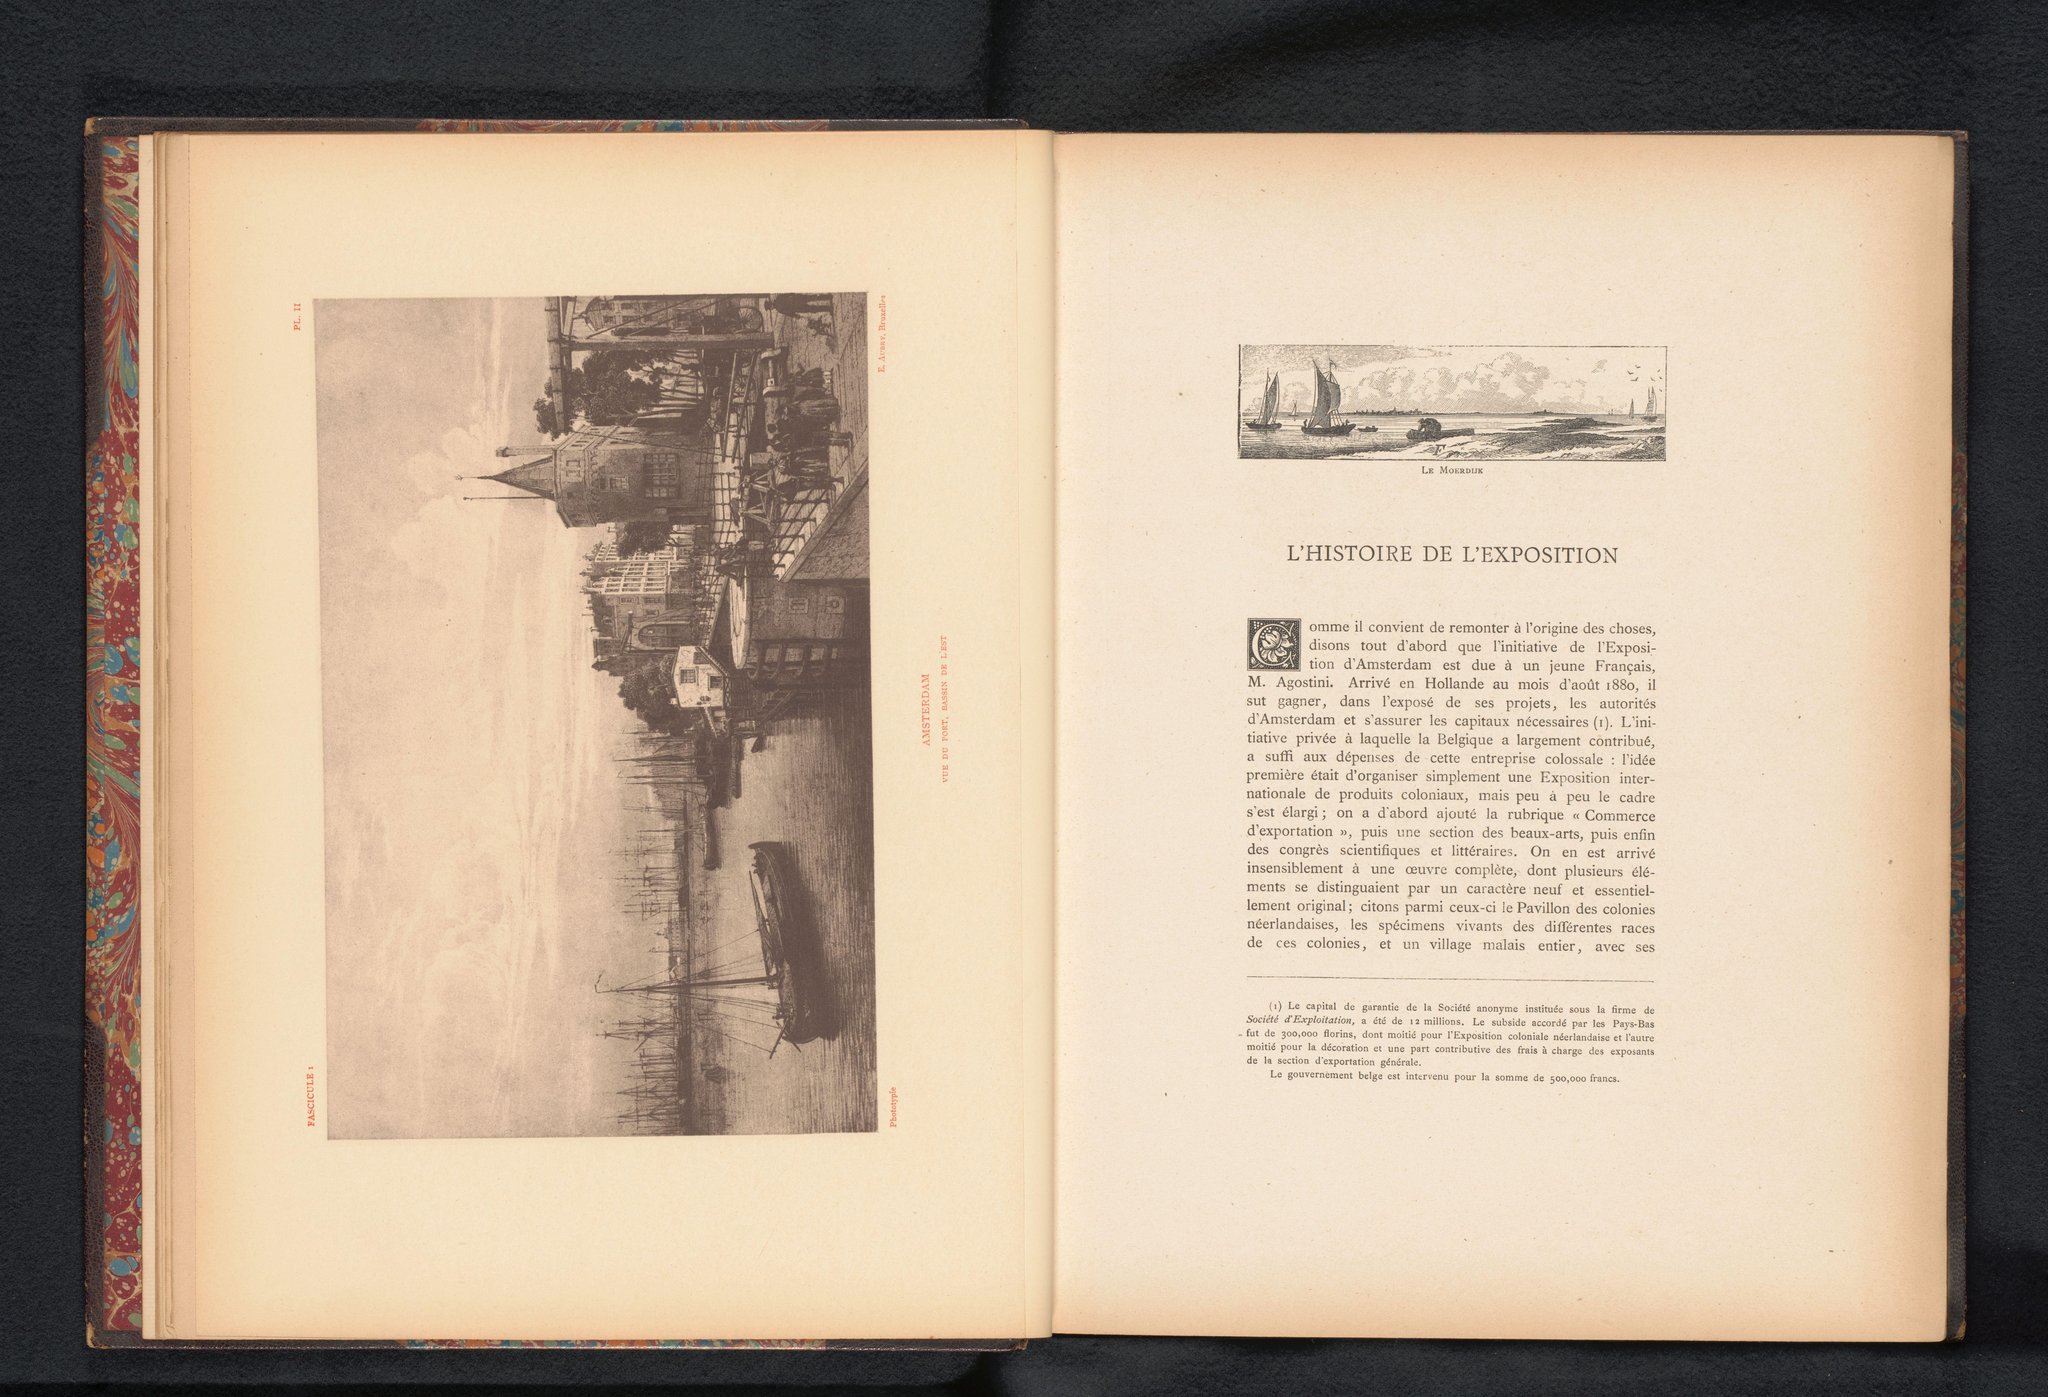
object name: reproduction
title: Reproductie van een prent van een gezicht op de haven van Amsterdam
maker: emile aubry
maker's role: print maker, printer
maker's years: 1829-1900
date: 1878-1883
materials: paper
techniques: photograph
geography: brussels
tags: harbour (+ four persons or more ~ traffic and transport), amsterdam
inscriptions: inscription: ‘Fascicule I/ PL. II’